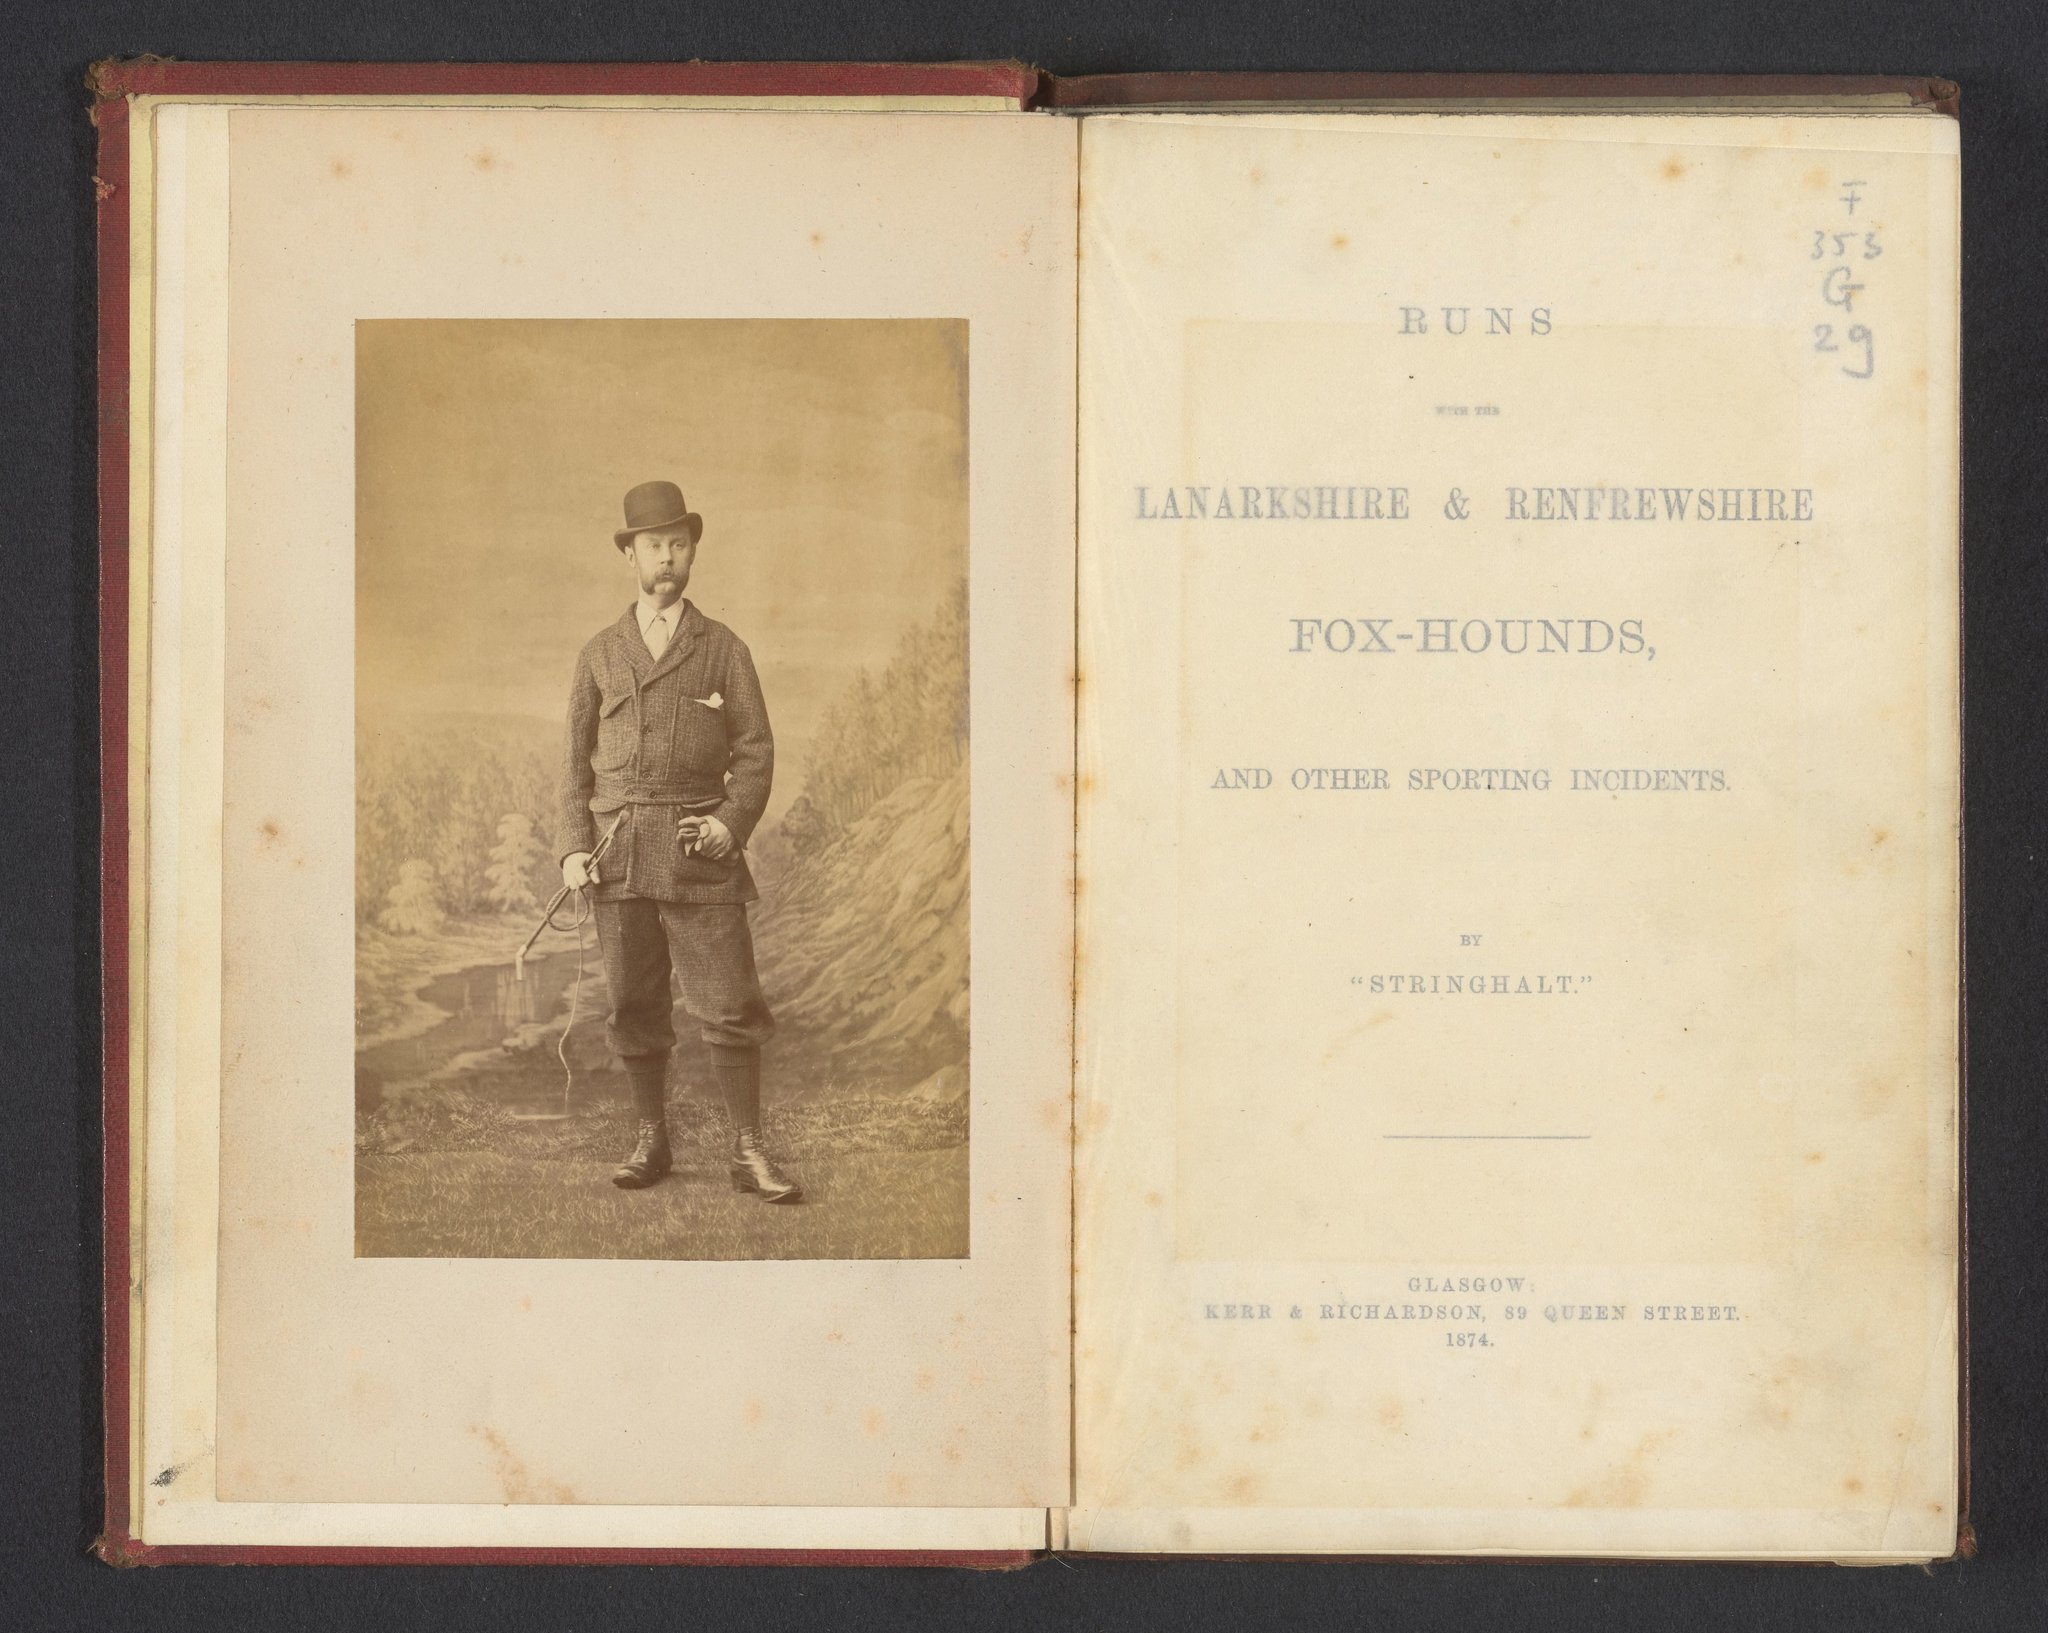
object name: photograph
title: Portret van een onbekende man in een jachtkostuum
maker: Anonymous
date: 1864-1874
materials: photographic support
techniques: albumen print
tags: hunter, fox hunting